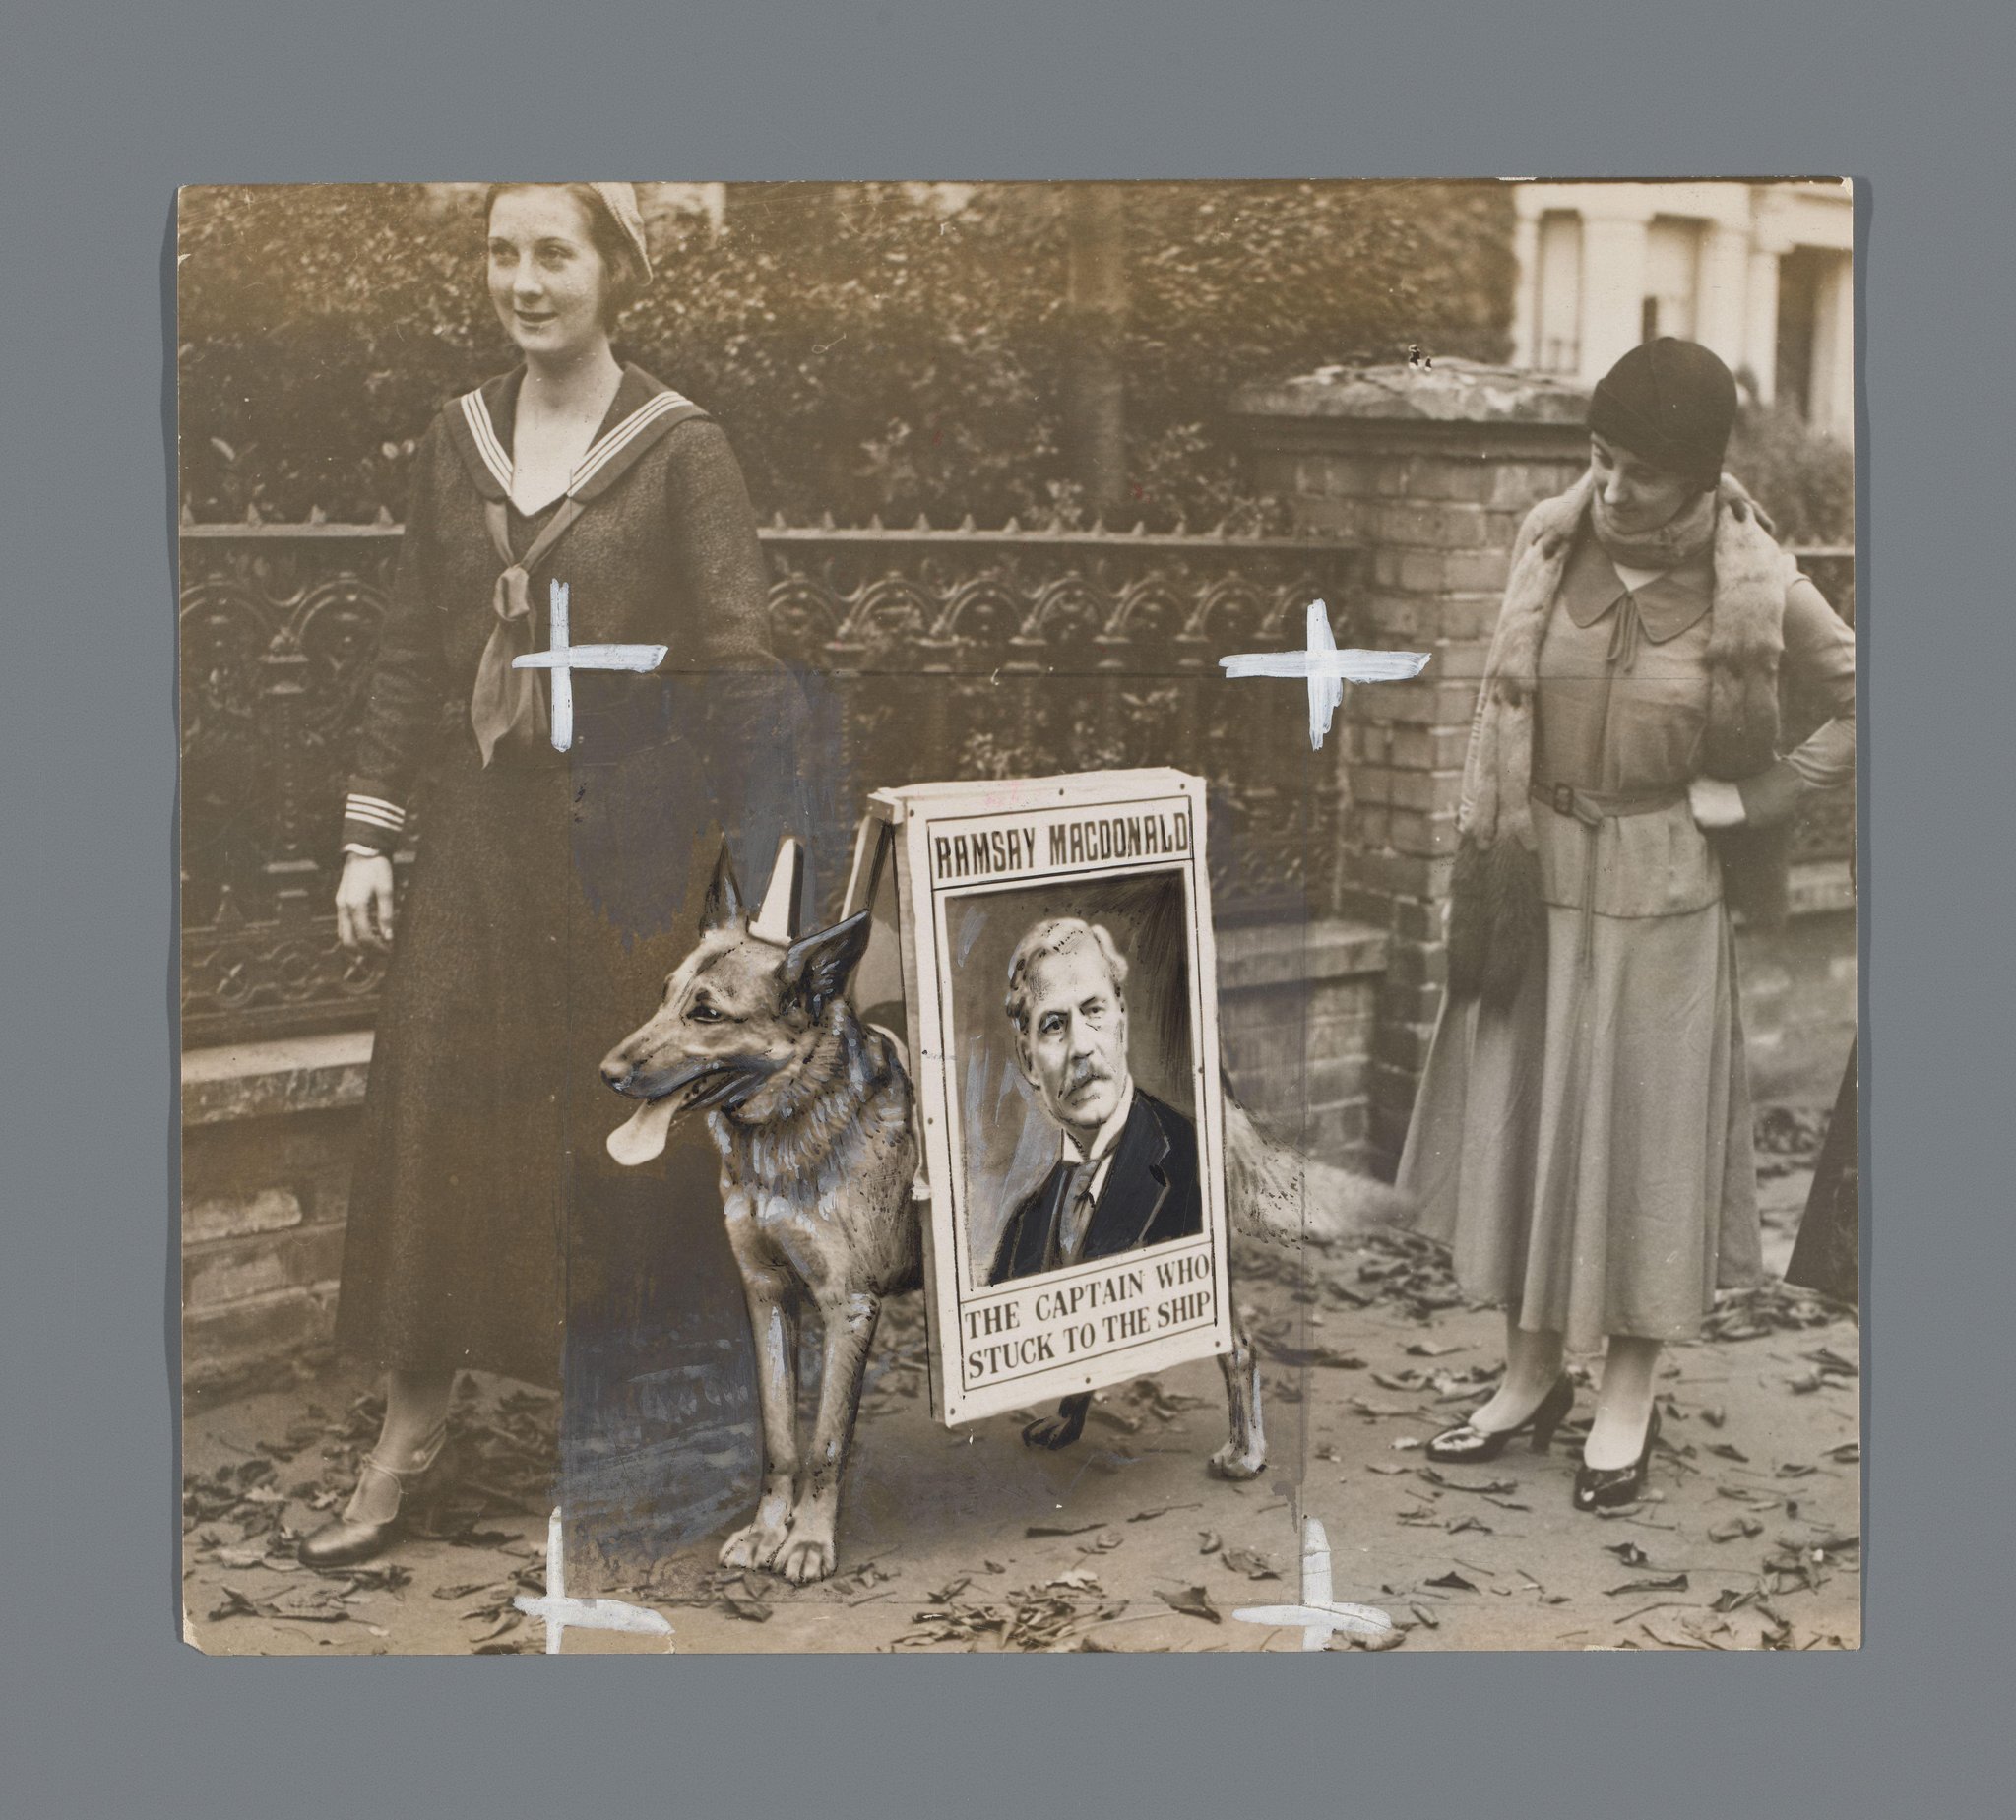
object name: photograph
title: Twee vrouwen met een hond en een verkiezingsbord voor Ramsay MacDonald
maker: Anonymous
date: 1931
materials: ink, photographic support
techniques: collodion silver print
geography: london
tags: atlantic ocean, united kingdom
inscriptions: stamp: ‘LONDON NEWS AGENCY PHOTOS LTD / PHOTO SUPPLIED L.N.A. / TEL. GENERAL 6528 / 46 FLEET STREET. LONDON L.C.A.’, inscription: ‘ISSUED. 19-10-31. / SUPPLIED. L.N. A. / DOING HIS BIT. / An Alsatien dog, in charge of Miss HARRIOT of FINCHLEY acts as a ‘’sandwich man’’ in support of the National Government.’